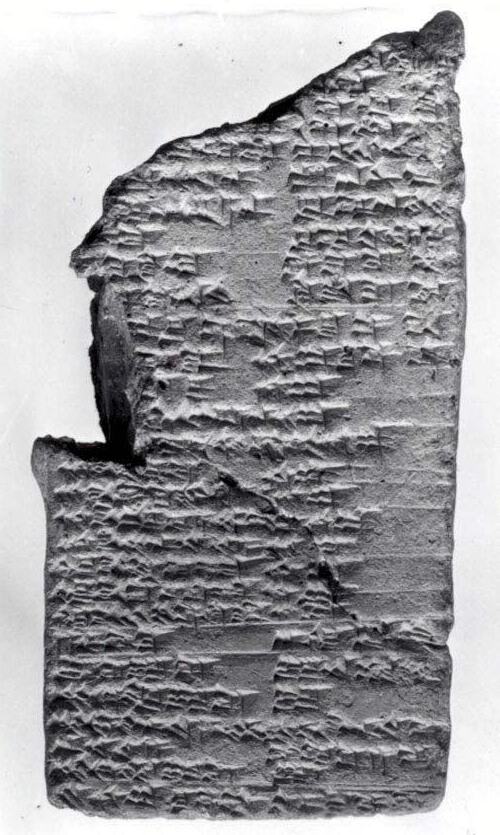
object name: cuneiform tablet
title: Cuneiform tablet: collection of ershemmas (nos. 45, 59, 53)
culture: parthian or seleucid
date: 367-400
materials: clay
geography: mesopotamia